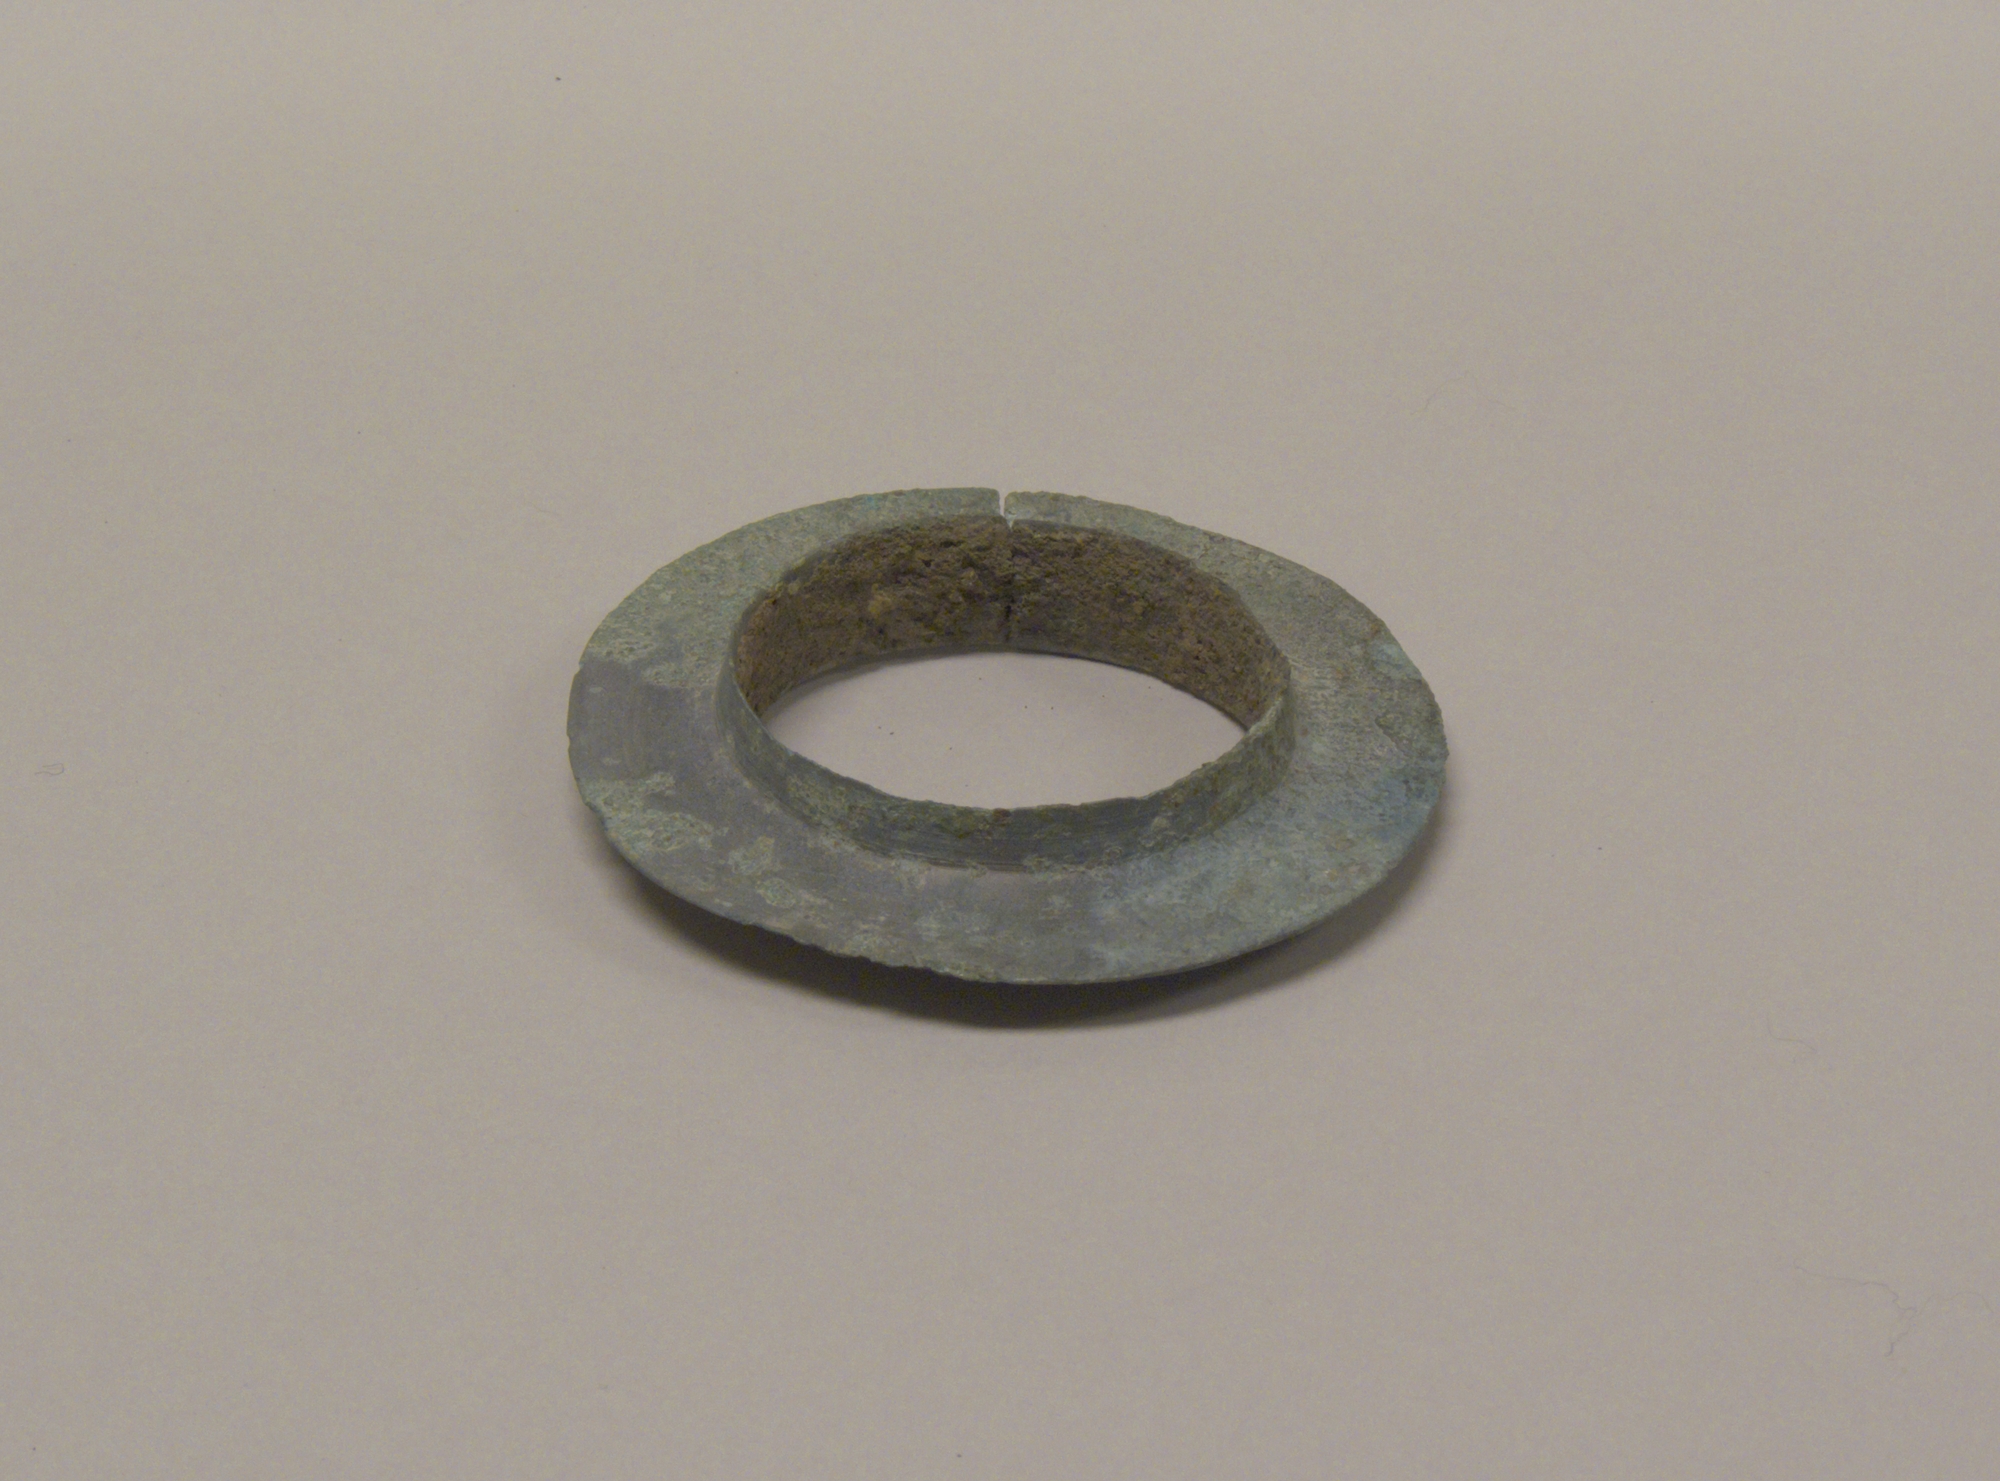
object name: bangle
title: Bangle with Wide raised Flange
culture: thai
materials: bronze